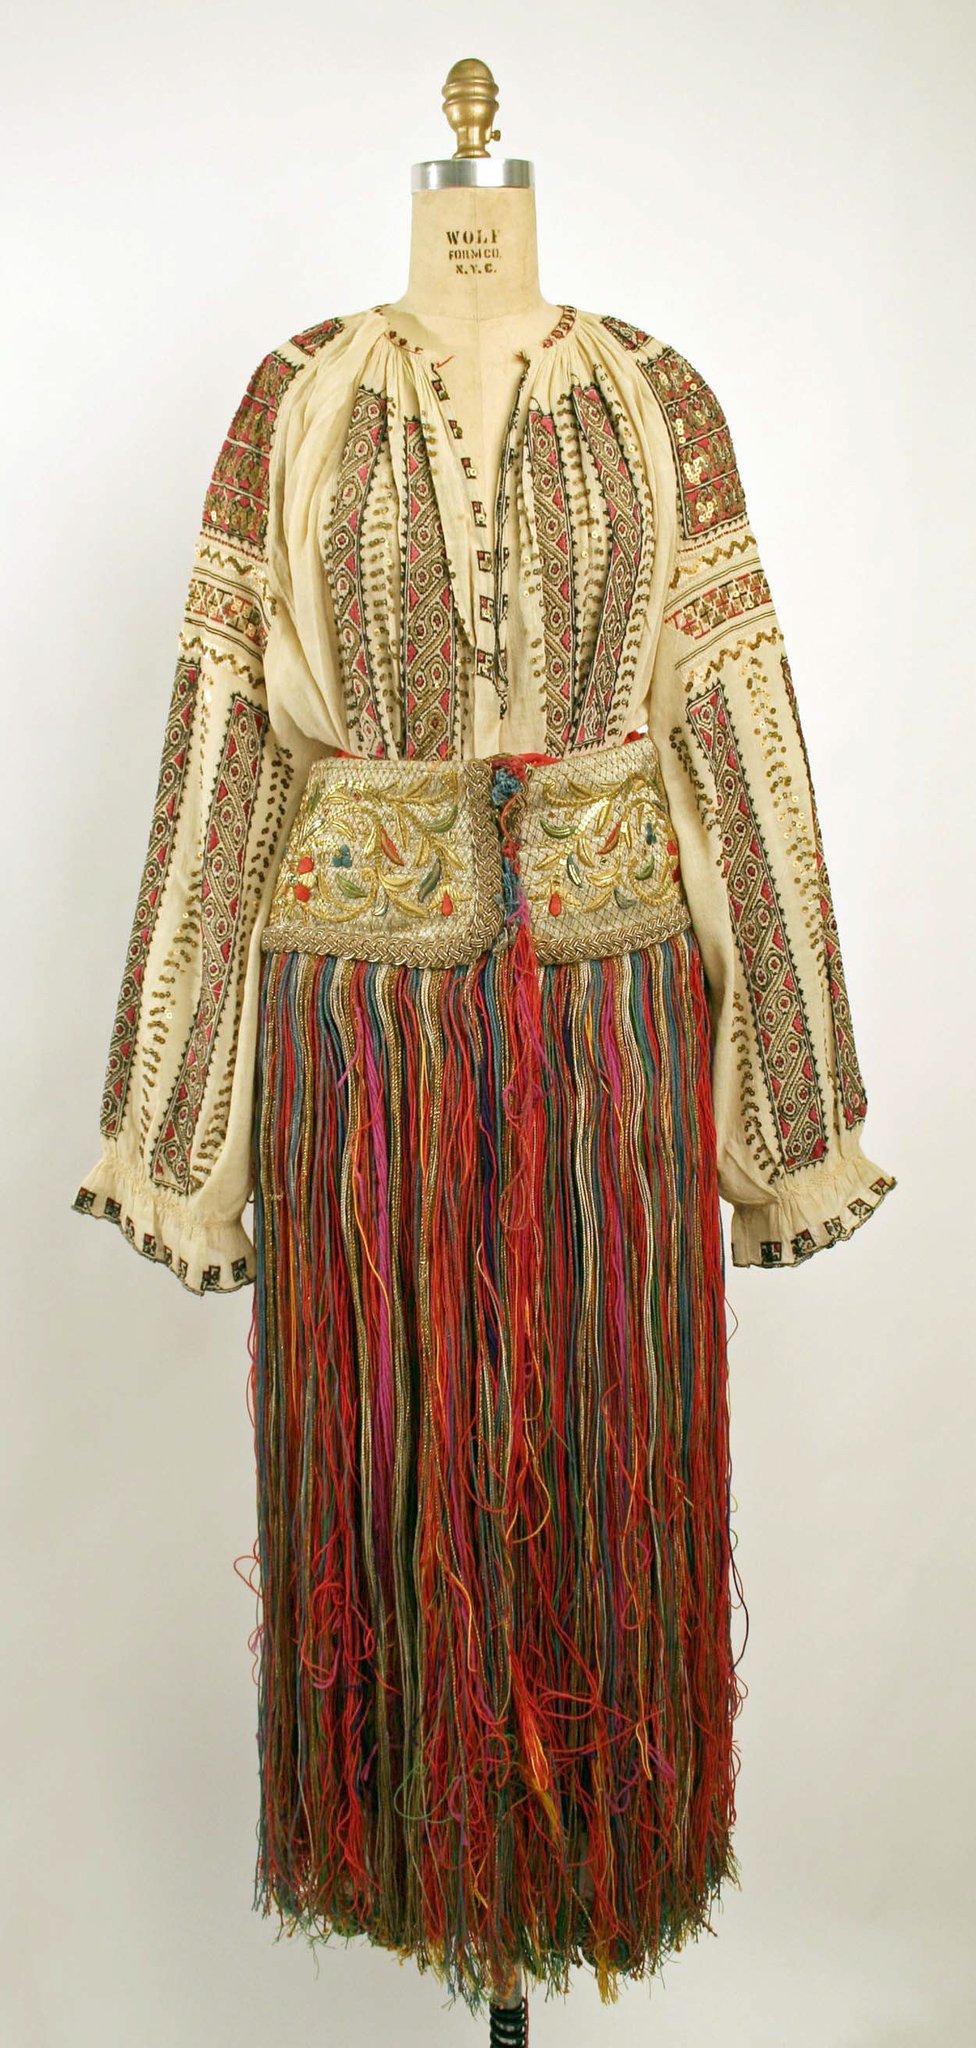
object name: dress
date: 1801-1900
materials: cotton, silk, wool